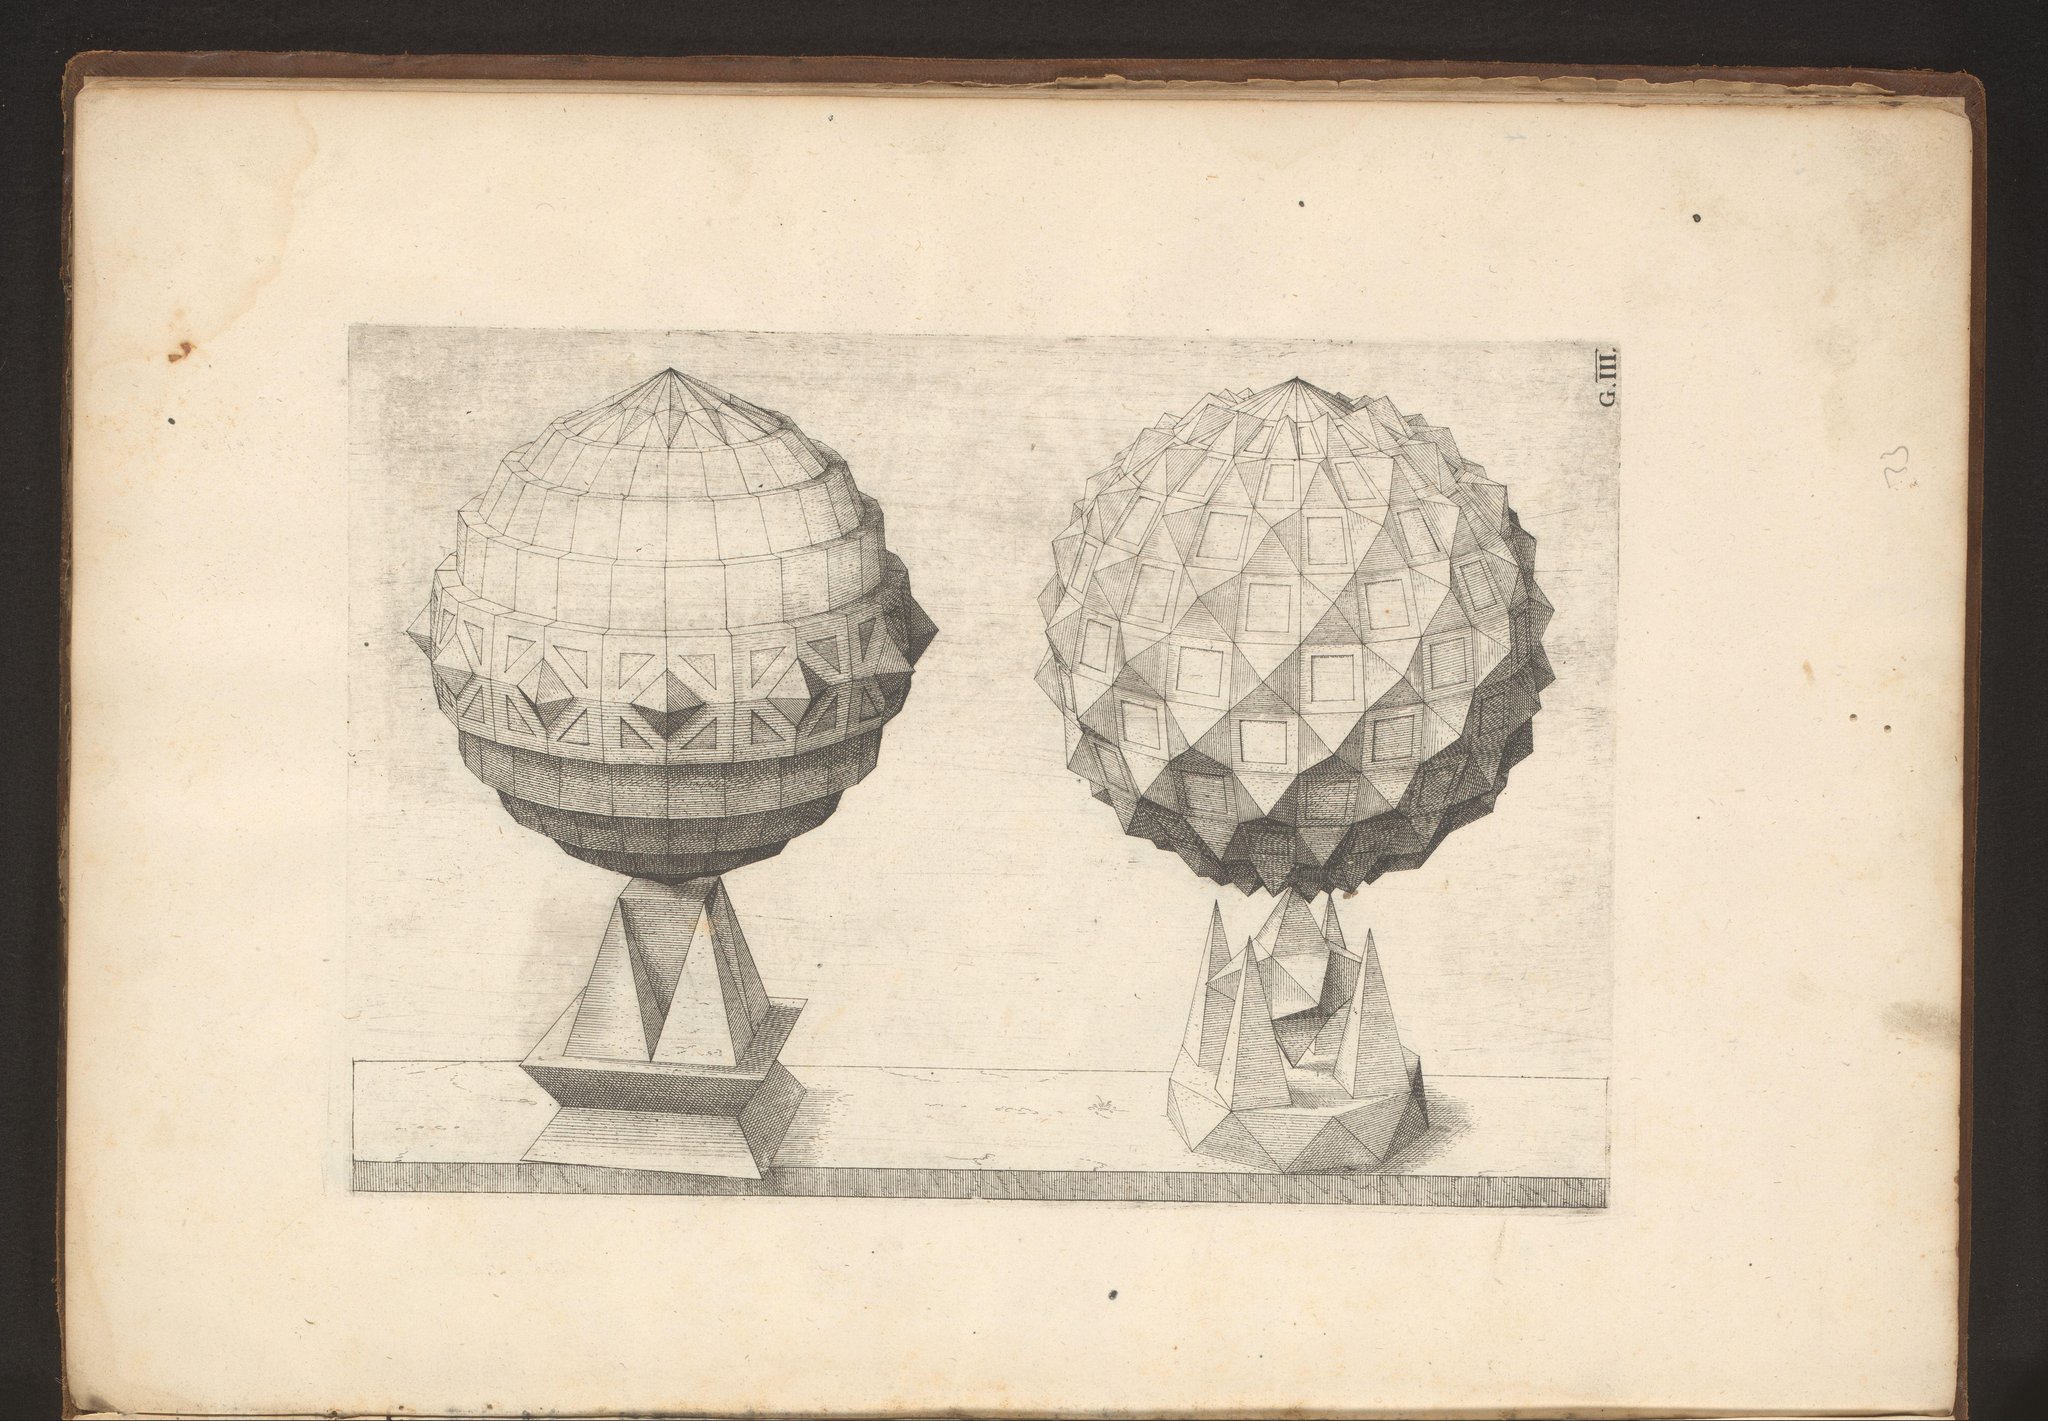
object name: print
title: Twee veelvlakken met een bol als uitgangspunt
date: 1568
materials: paper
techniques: etching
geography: nuremberg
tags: sphere, globe ~ stereometry, other polyhedrons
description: De geometrische figuren (polyhedra) worden van links naar rechts complexer. Genummerd: G.III. Deze prent maakt deel uit van een boek.